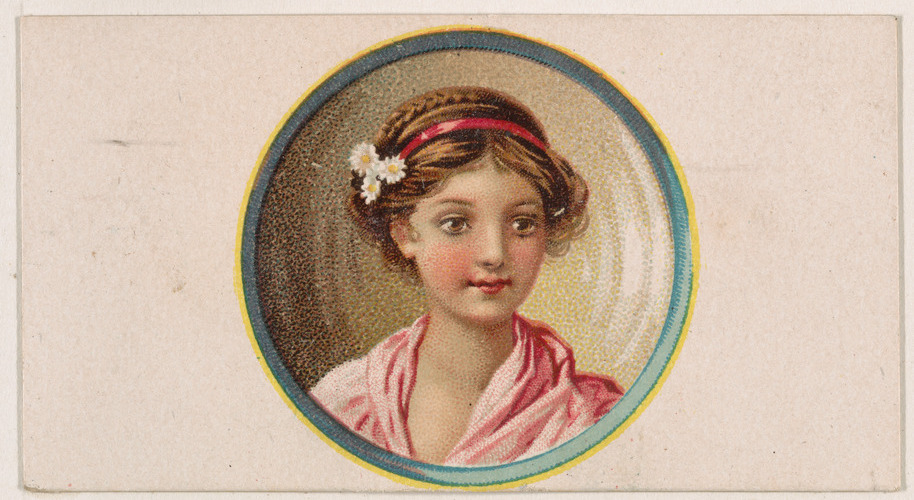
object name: print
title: Plate, from the Novelties series (N228, Type 5) issued by Kinney Bros.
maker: kinney brothers tobacco company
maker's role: publisher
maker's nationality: american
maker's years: 1869-2011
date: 1889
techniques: color lithograph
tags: women